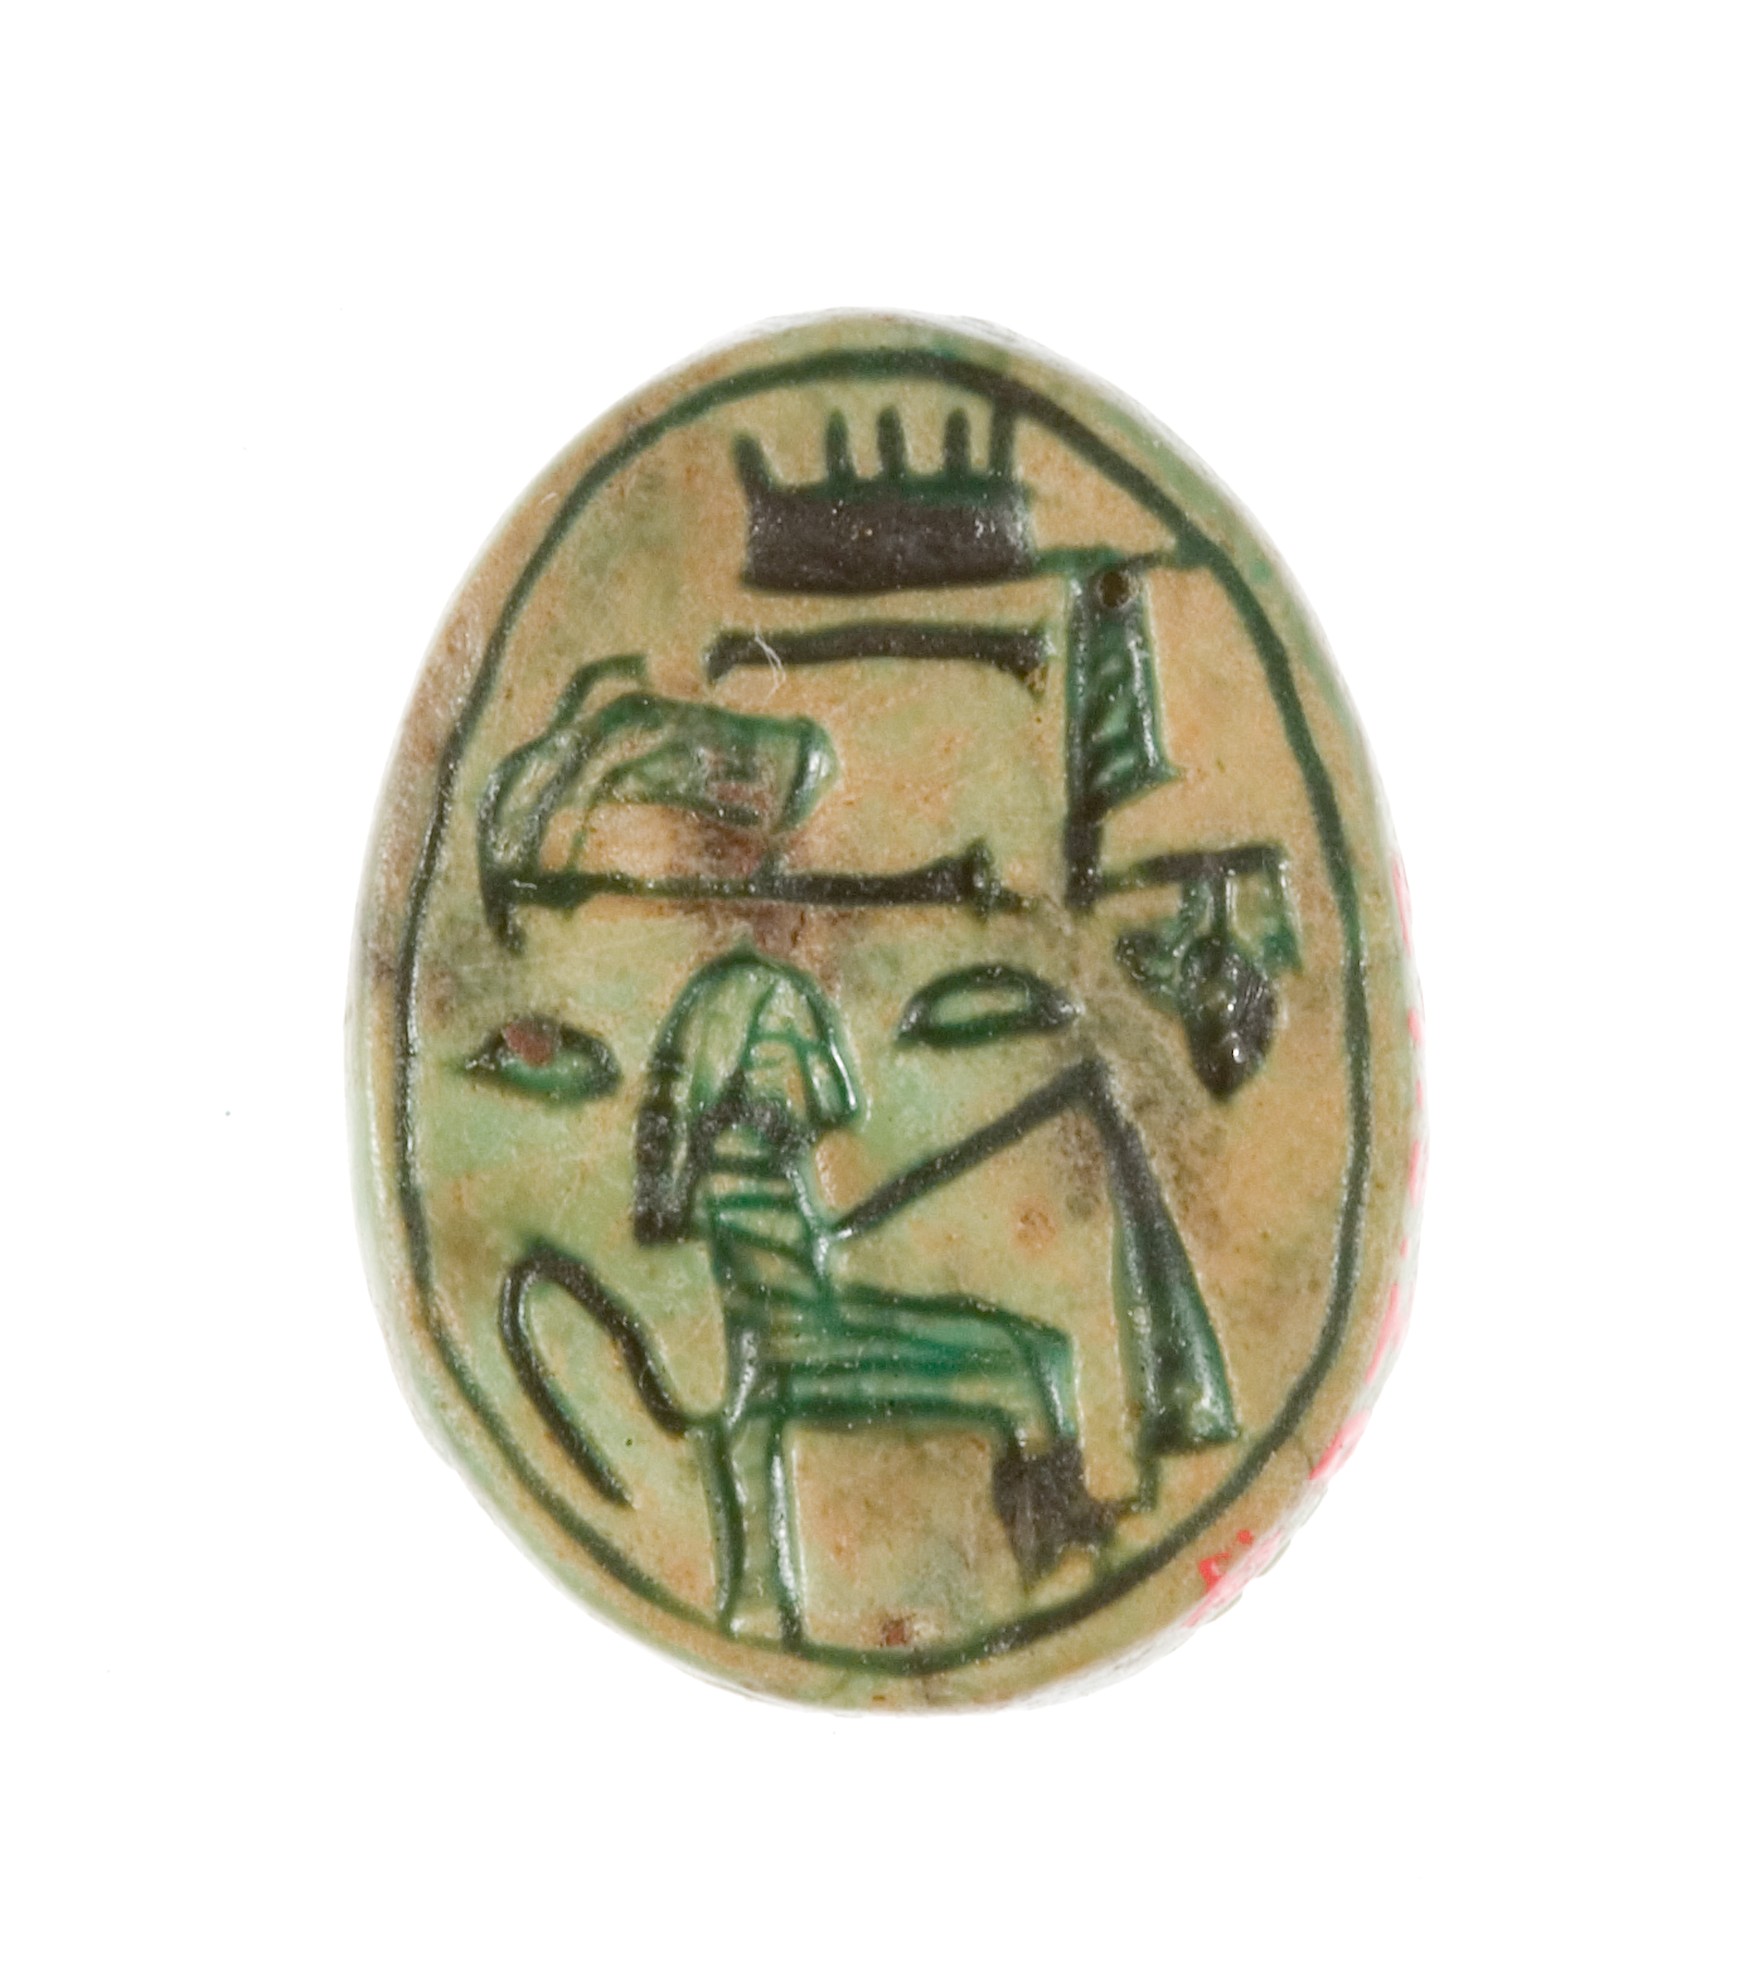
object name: scarab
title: Scarab Inscribed Hatshepsut United with Amun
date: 1479-1458 BCE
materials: stone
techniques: glazing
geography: egypt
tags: hieroglyphs,amun,scarabs